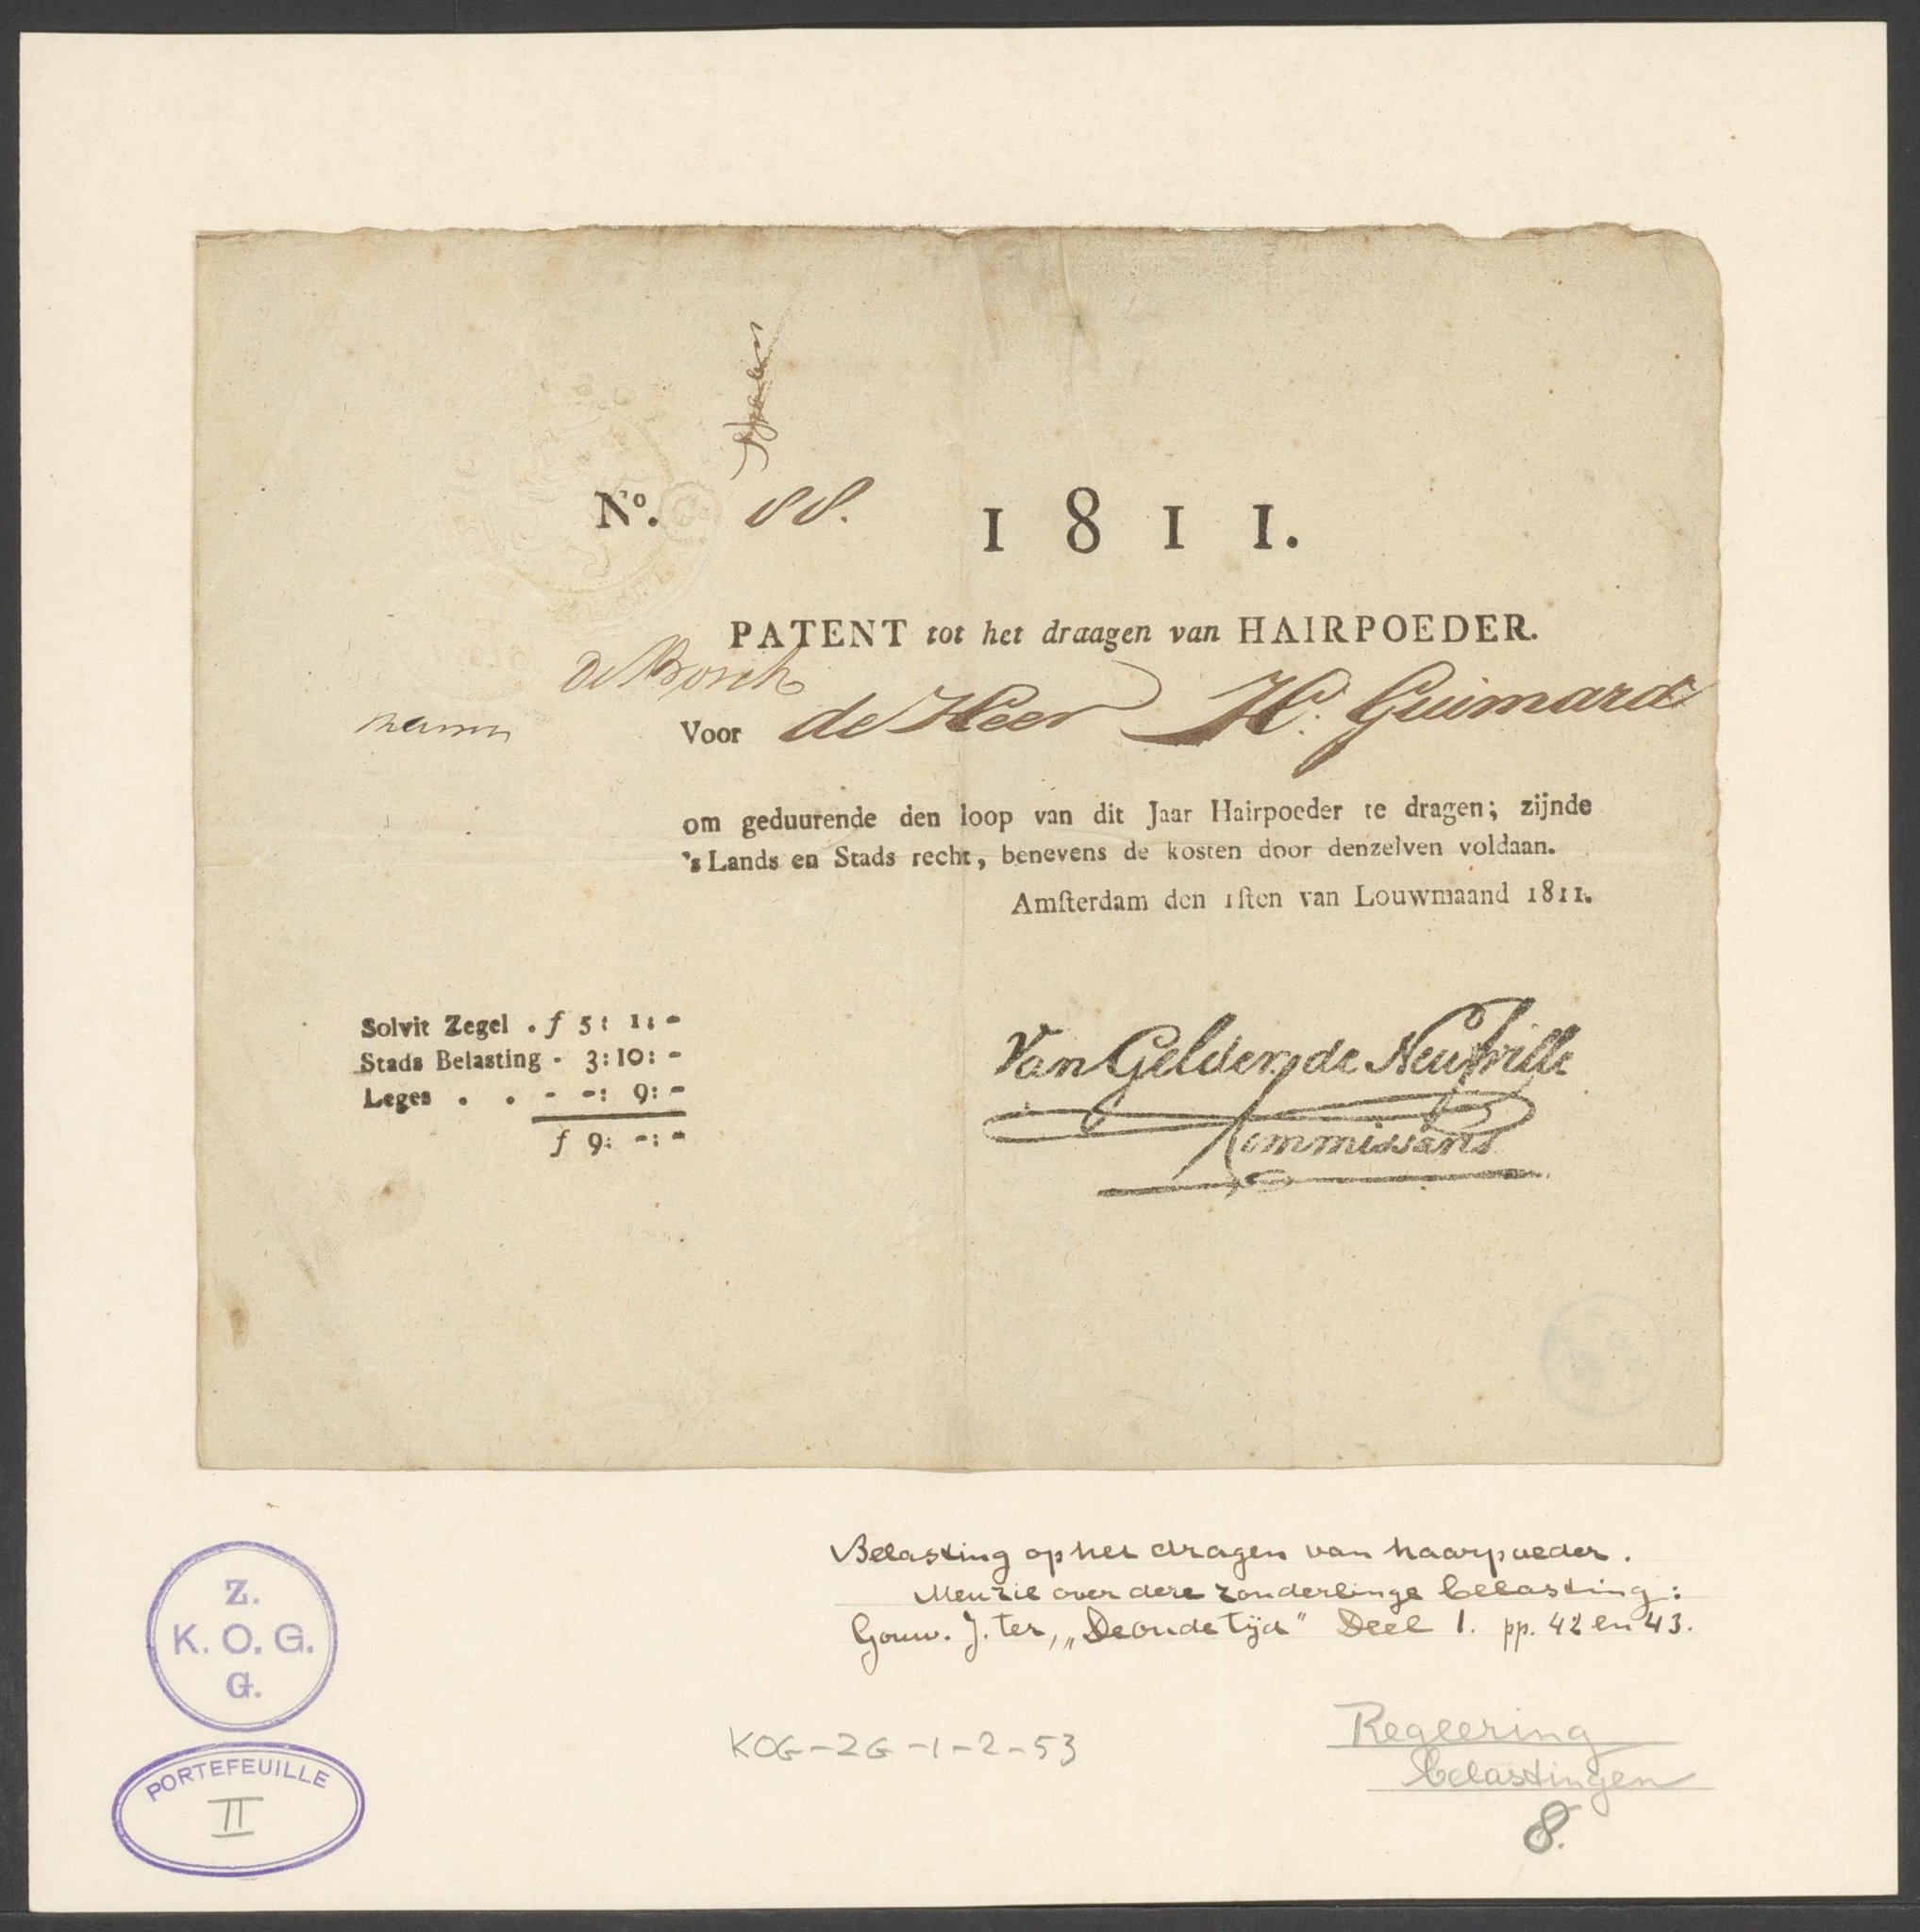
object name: text sheet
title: Patent tot het draagen van Hairpoeder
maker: Anonymous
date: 1811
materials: paper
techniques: blind stamped, letterpress printing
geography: amsterdam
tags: tax collection, wig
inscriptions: collector's mark: Lugt 1641, collector's mark: Lugt 1641a, collector's mark:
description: Bewijs van betaling van de belasting op het dragen van haarpoeder, No. 88, op naam van dhr. Guimard, Amsterdam 1811. Met twee blindstempels. Voorgedrukt formulier, ingevuld met handschrift in pen. Onderwerpsrubrieken binnen de Atlas Zeden en Gewoonten: Regeering, Belasting.